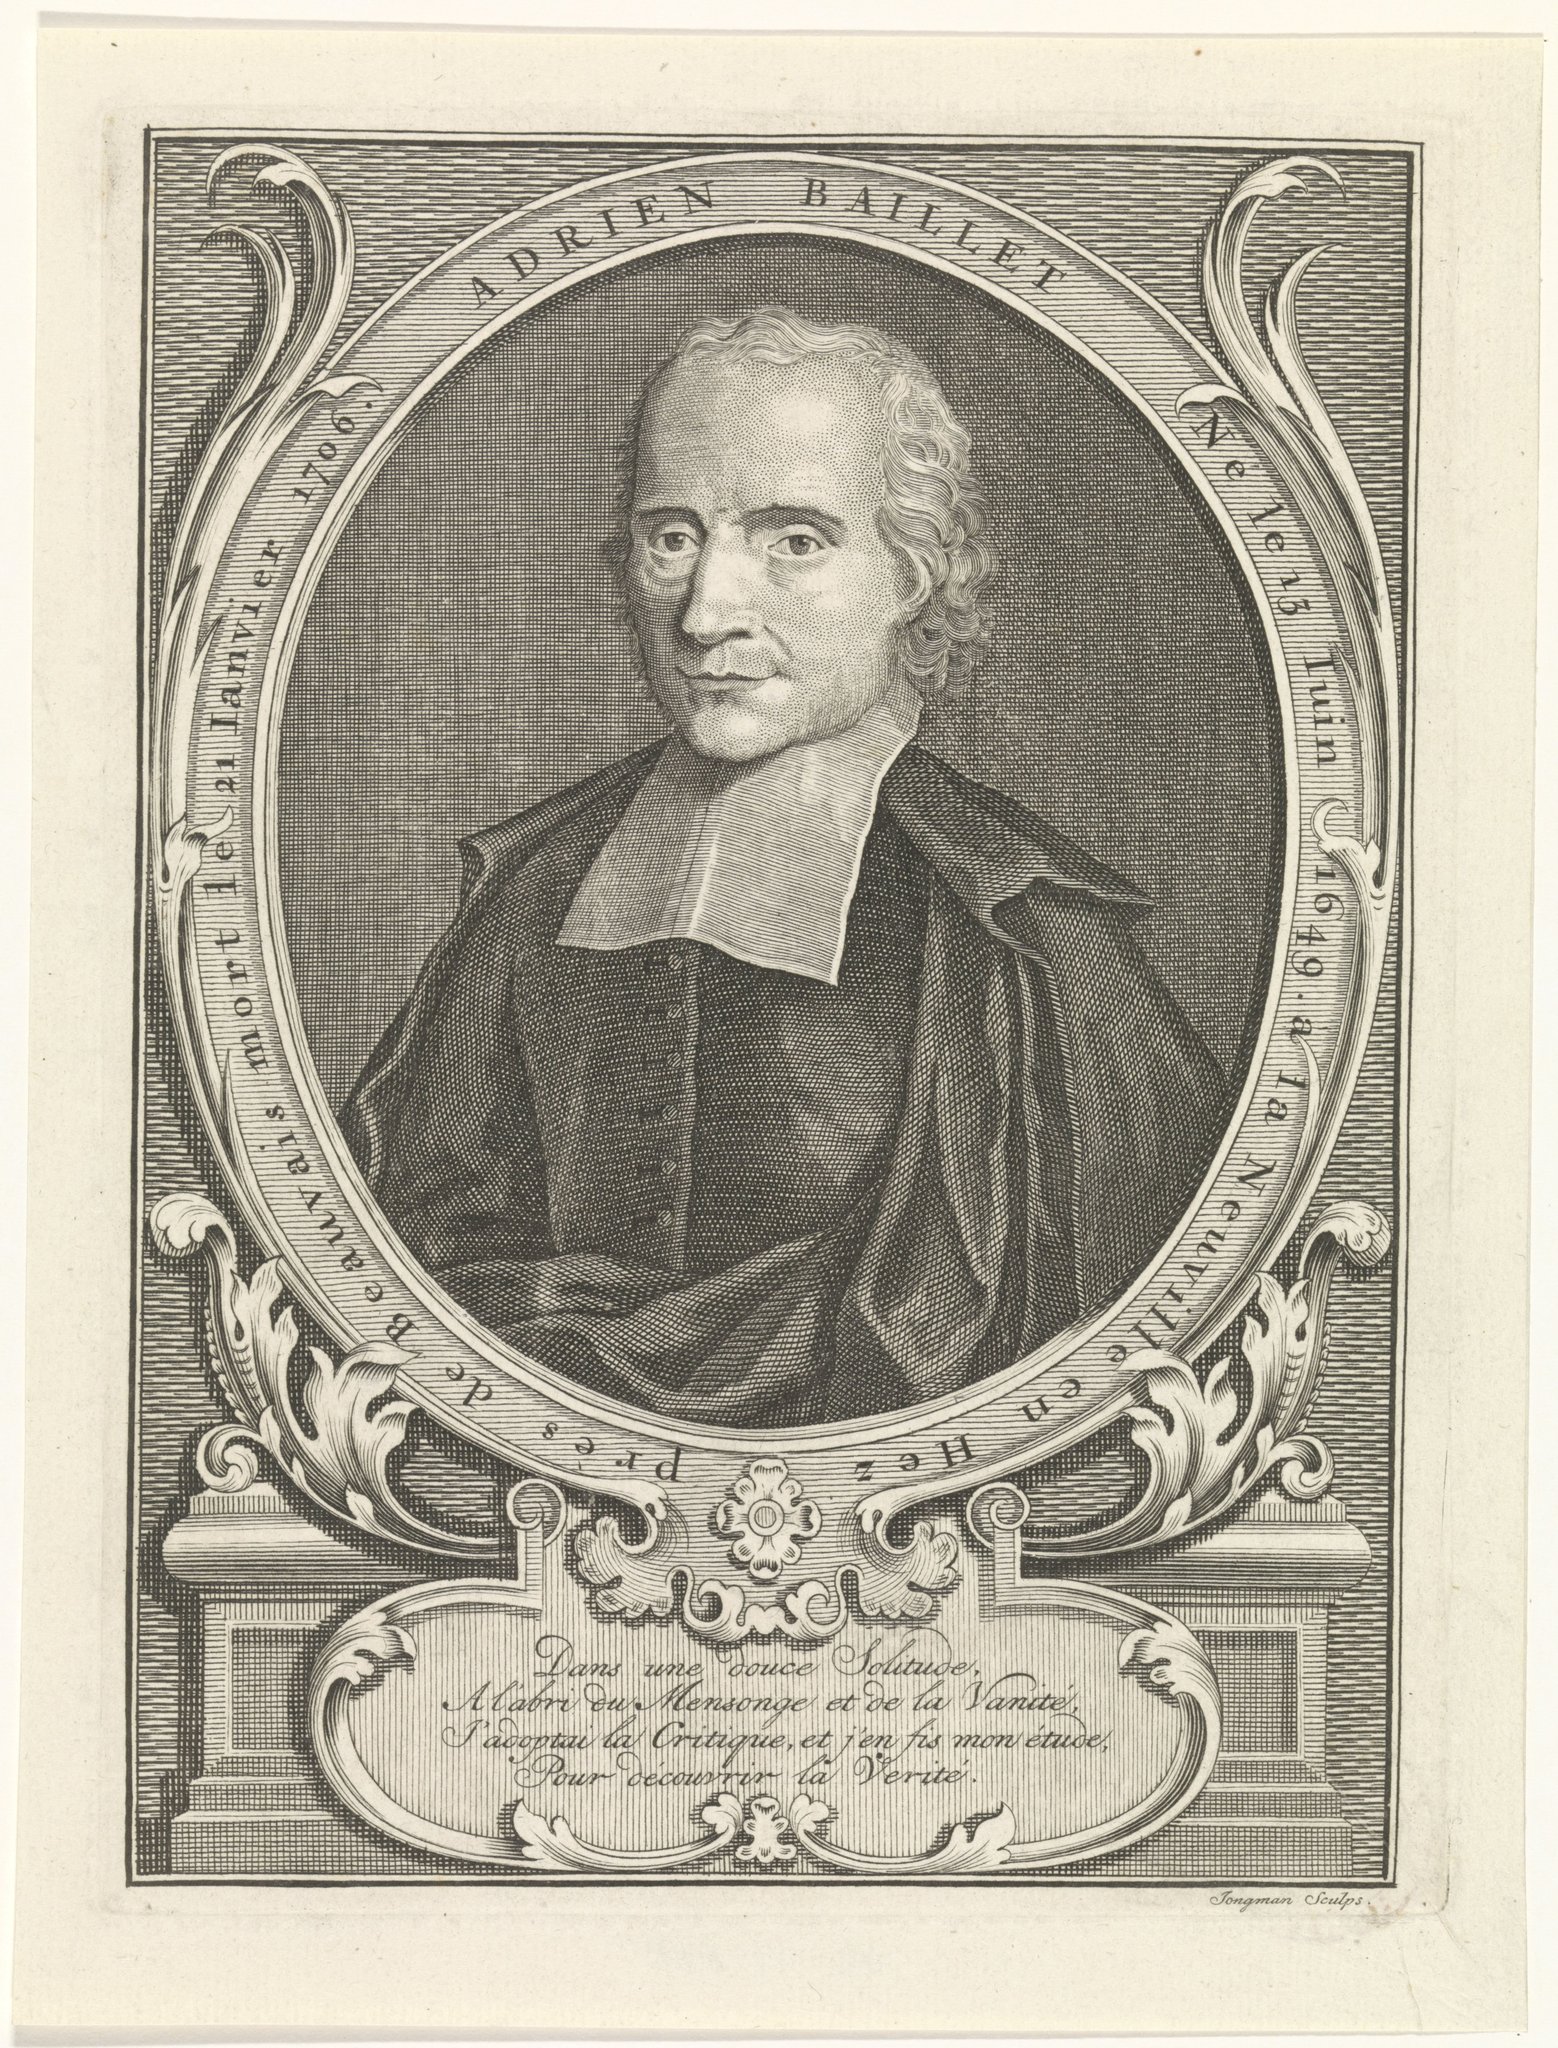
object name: print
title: Portret van Adrien Baillet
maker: dirk jongman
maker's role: print maker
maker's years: 1684-1726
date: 1709-1726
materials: paper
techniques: engraving, etching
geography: amsterdam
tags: paris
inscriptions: collector's mark: Lugt 240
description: Busteportret van de Franse geleerde Adrien Baillet. Het portret is gevat in een ovale omlijsting met een randschrift in het Frans. In een cartouche een vierregelig gedicht in het Frans.